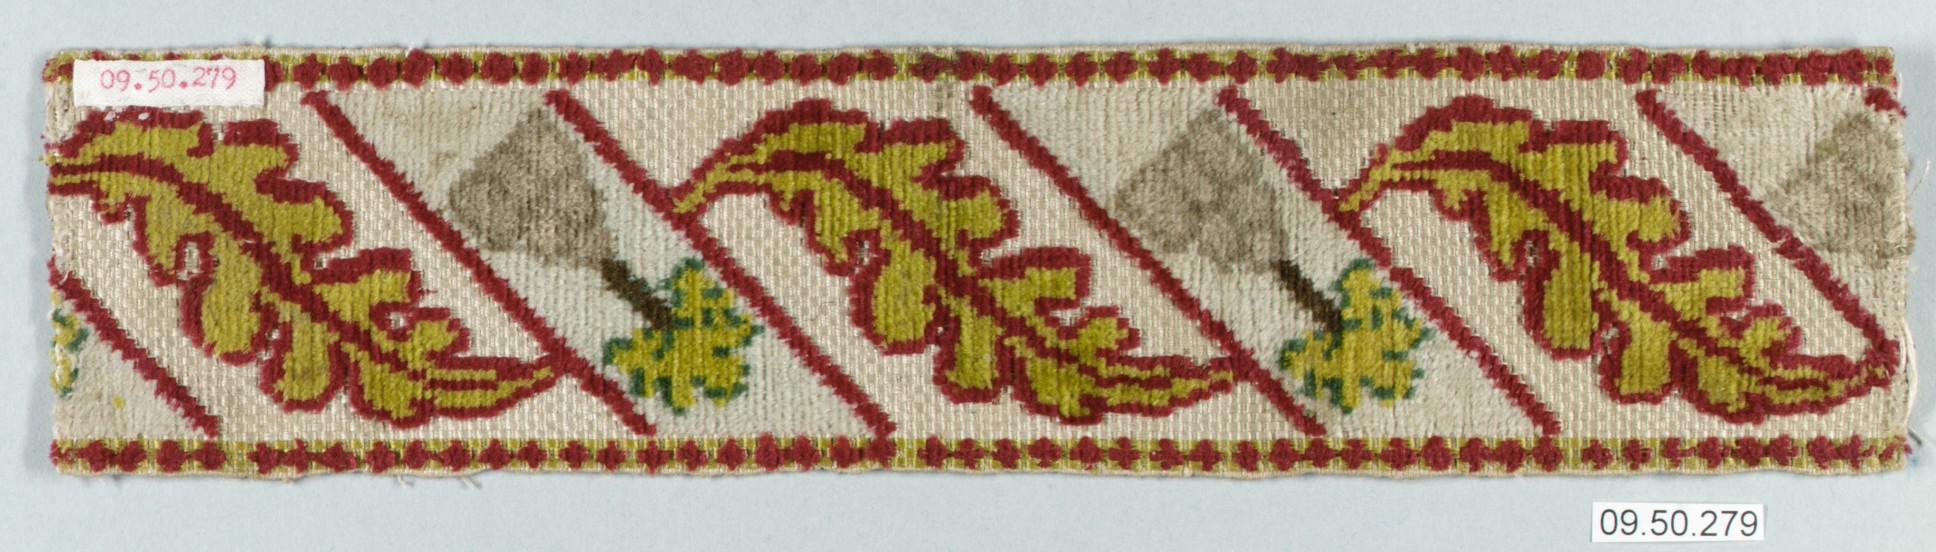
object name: galloon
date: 1701-1800